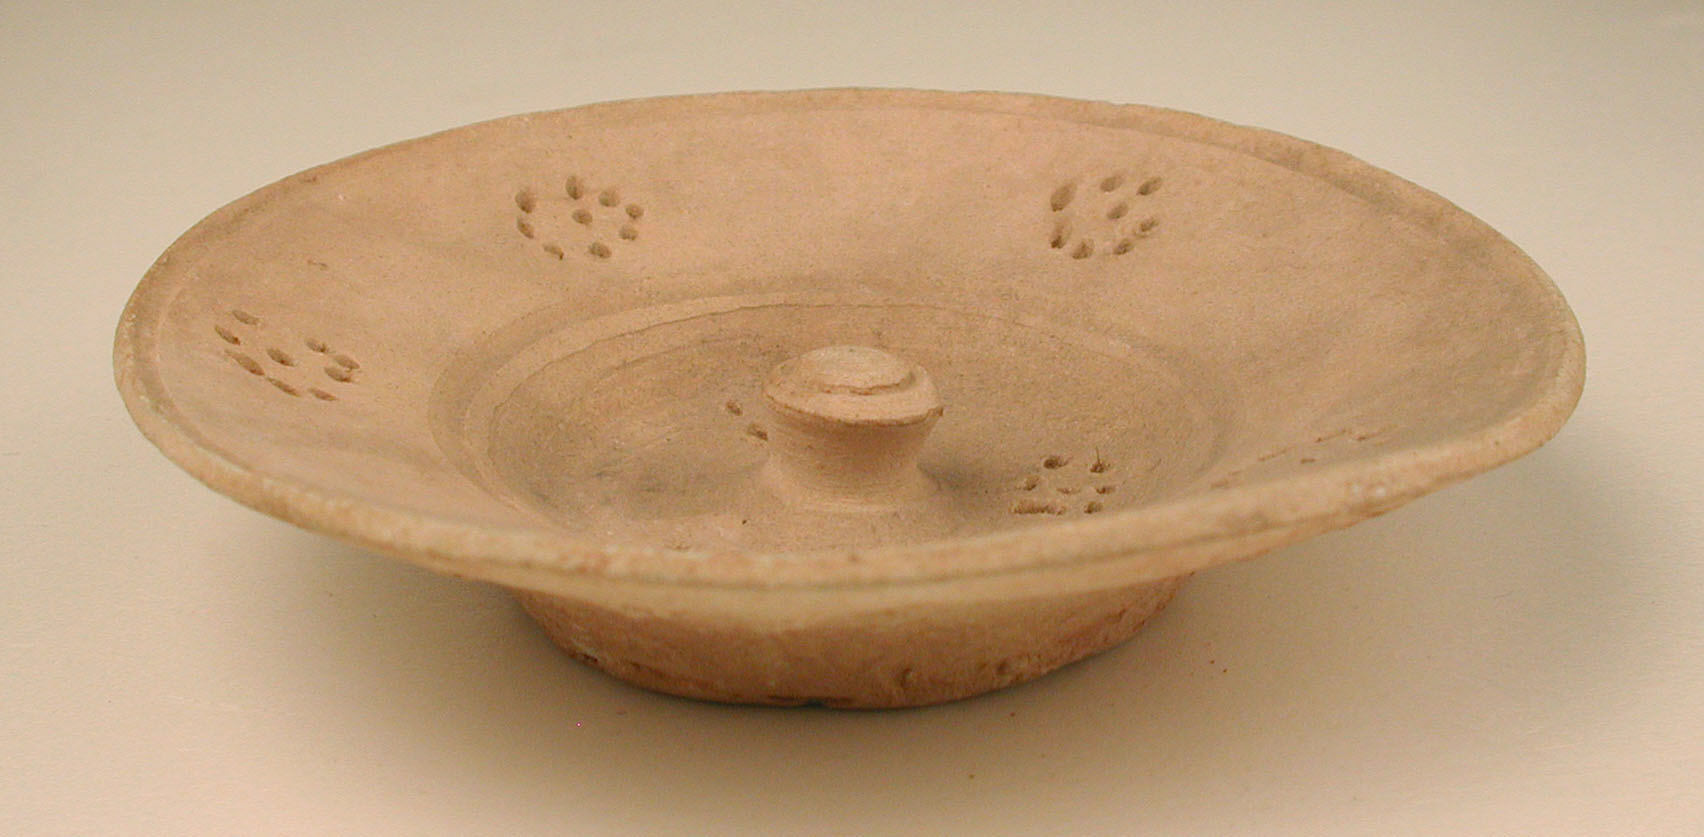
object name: lid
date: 1001-1200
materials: earthenware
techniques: incising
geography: iran